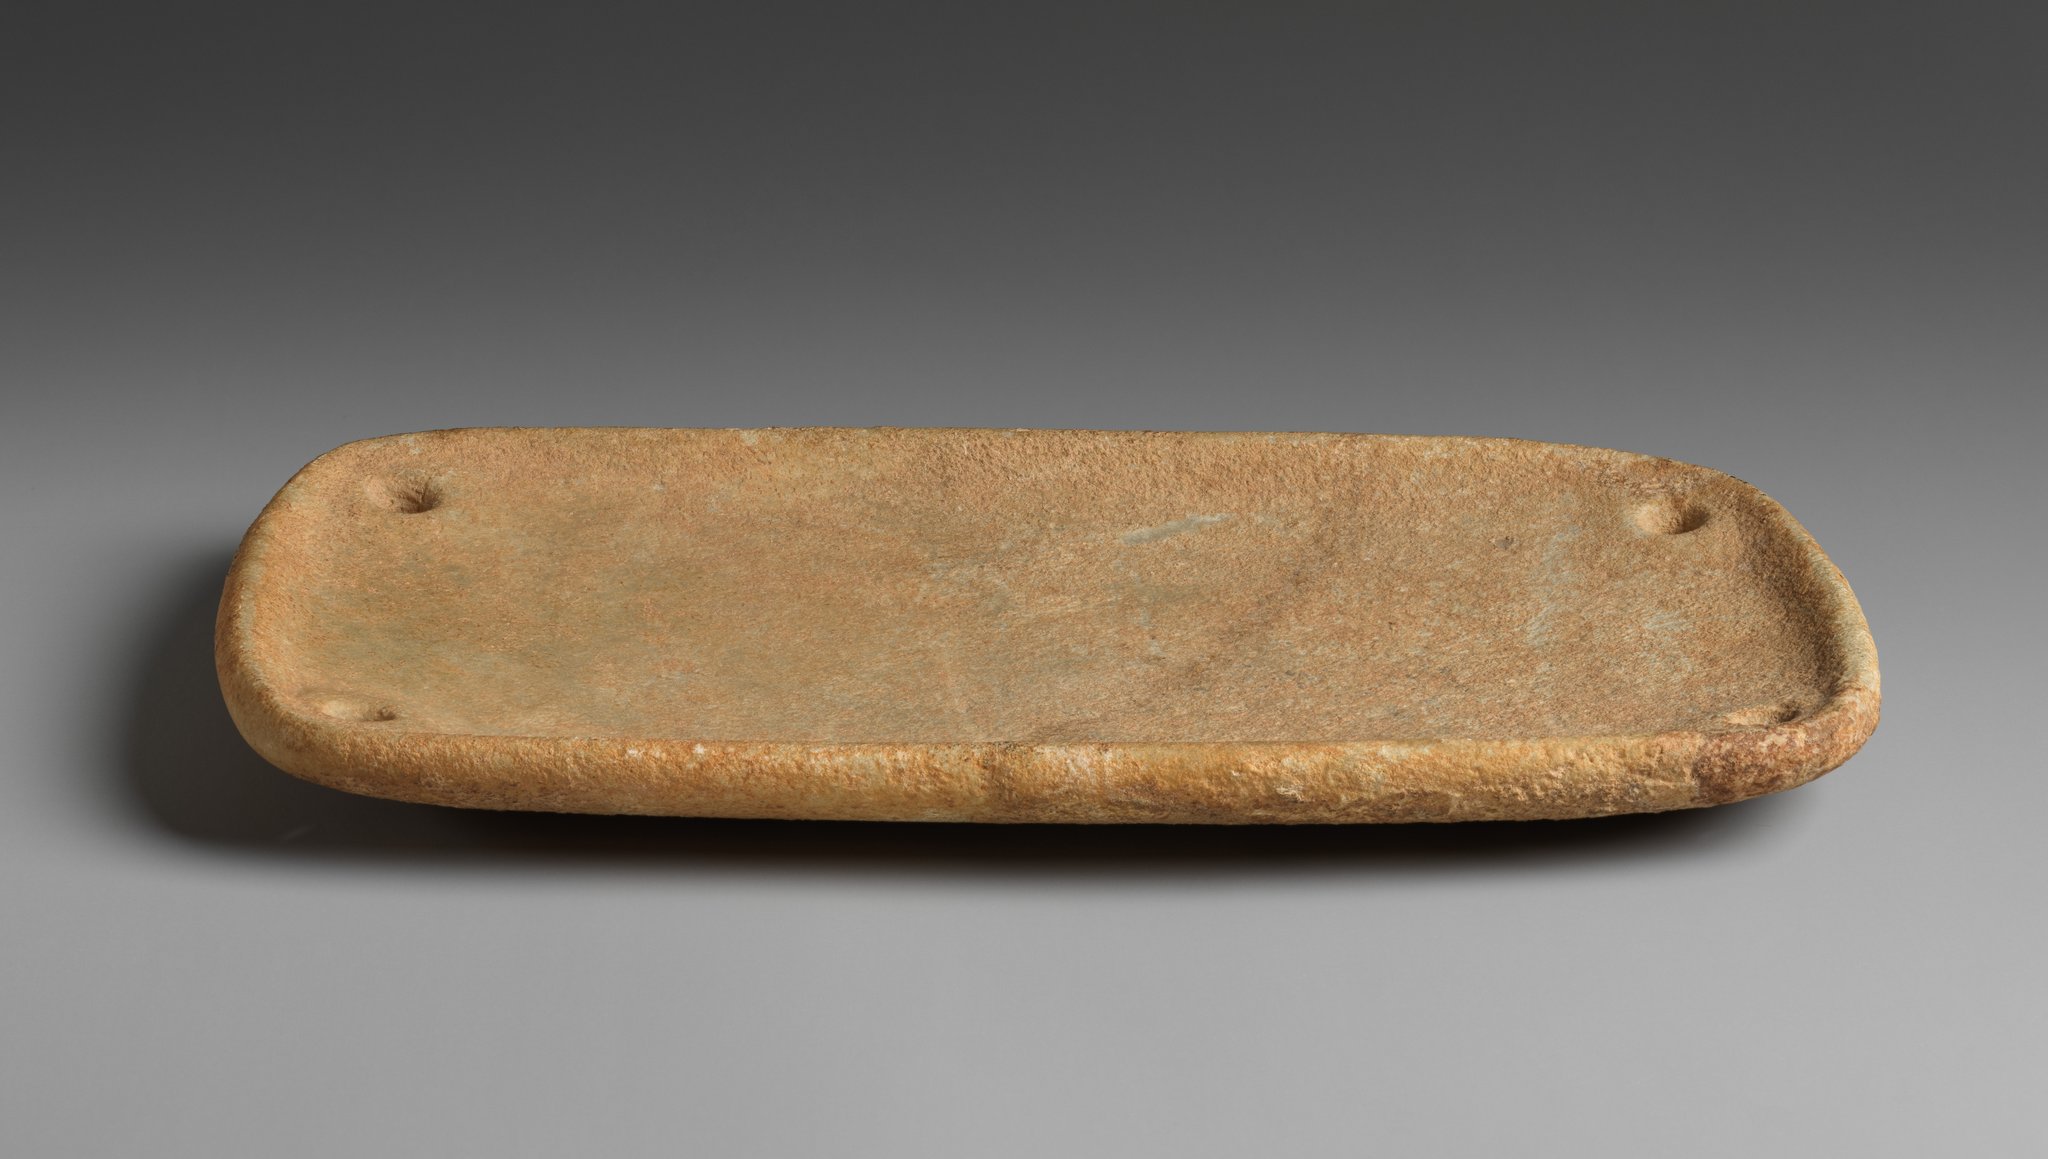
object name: palette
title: Marble palette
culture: cycladic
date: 3200-2800 BCE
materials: marble